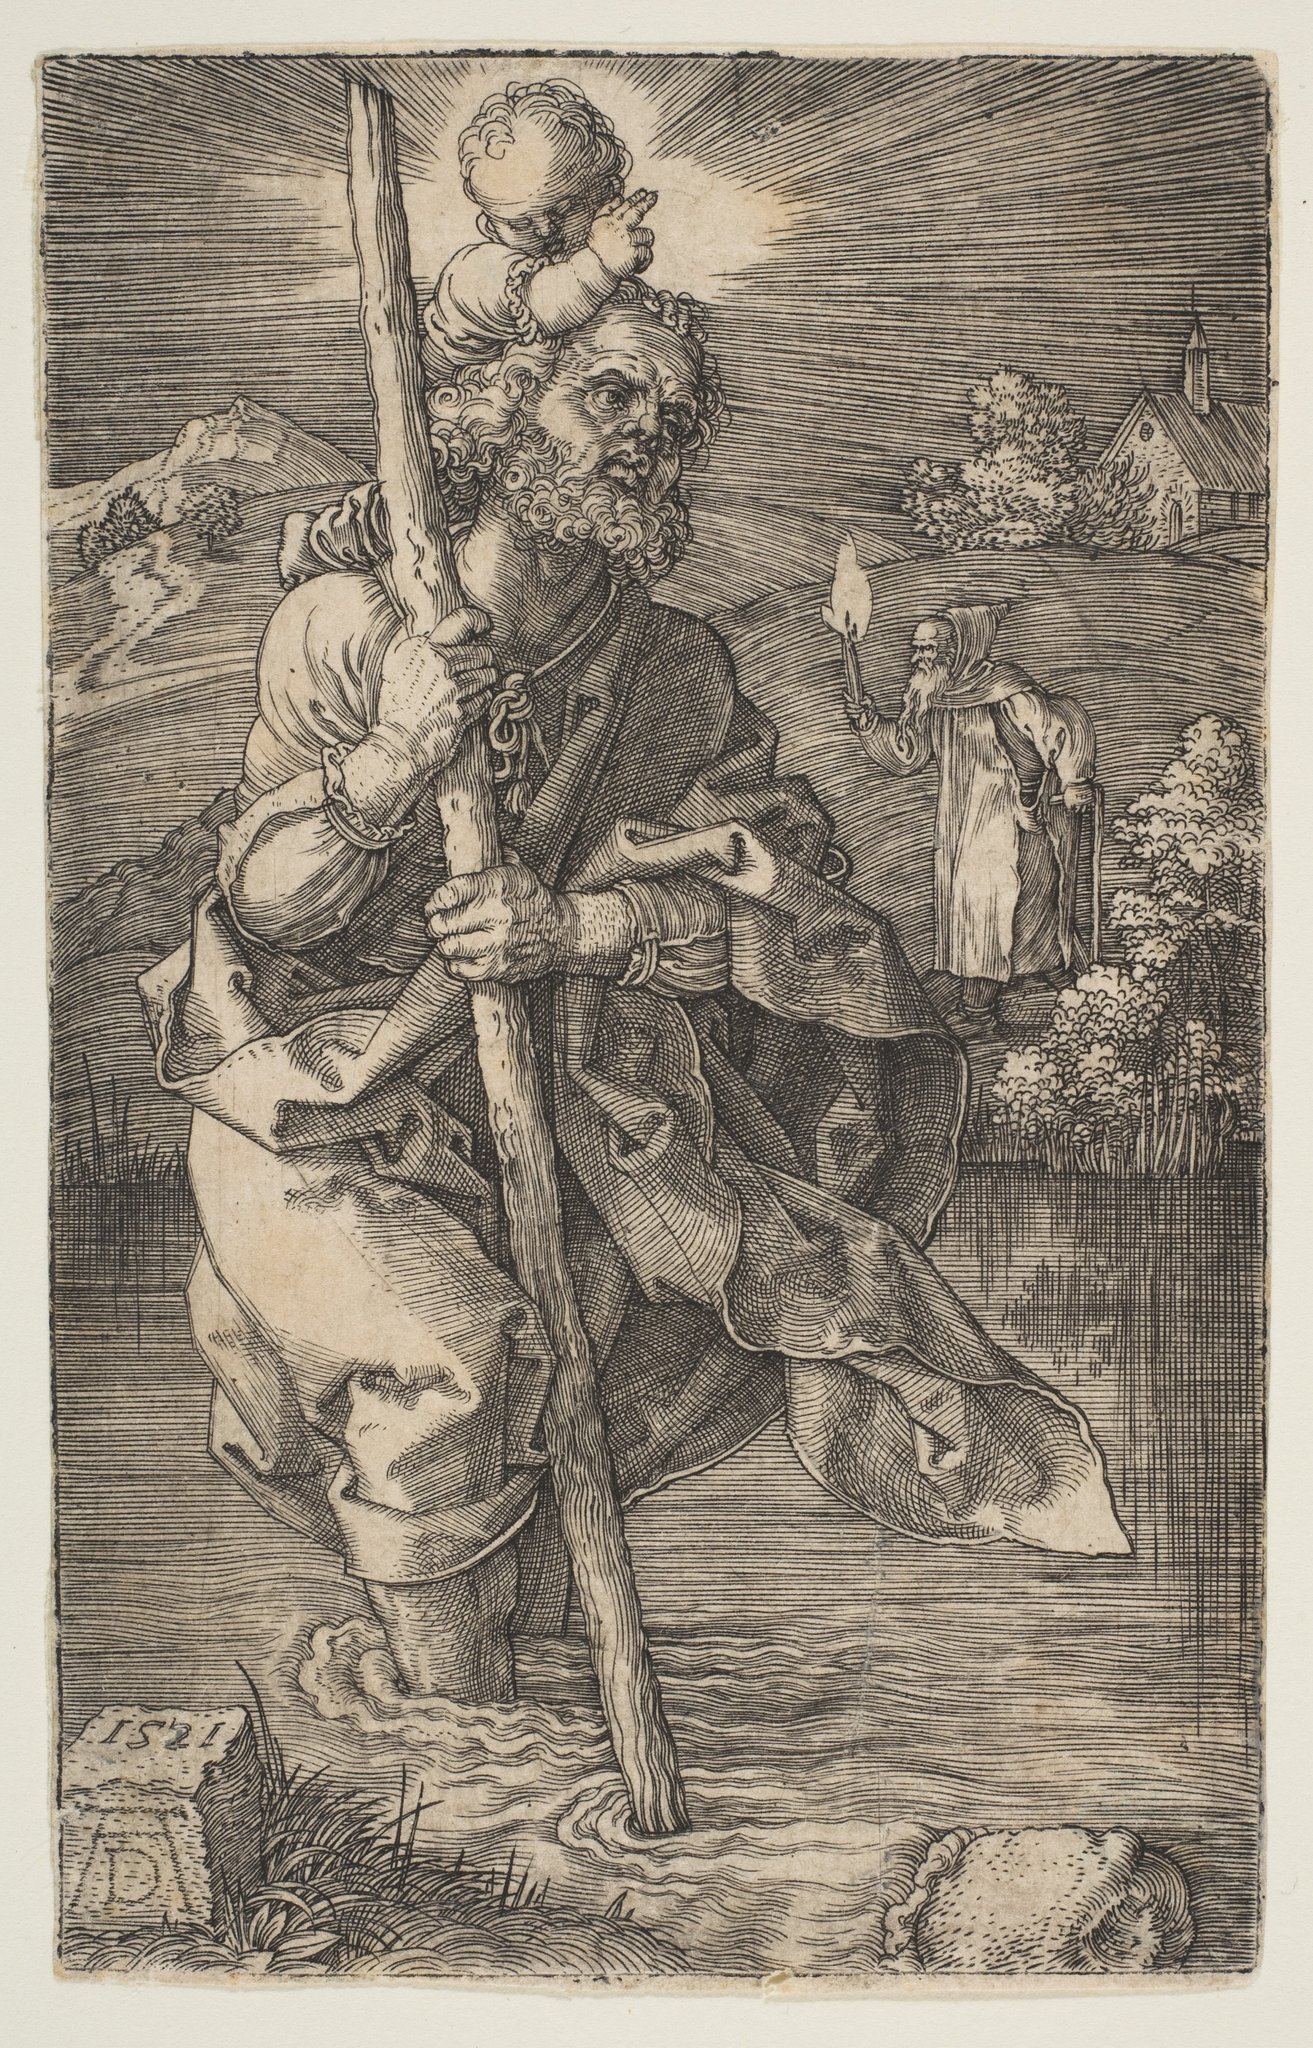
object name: print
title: Saint Christopher Facing Right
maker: albrecht dürer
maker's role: artist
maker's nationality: german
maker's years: 1471-1528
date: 1521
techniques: engraving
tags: saint christopher